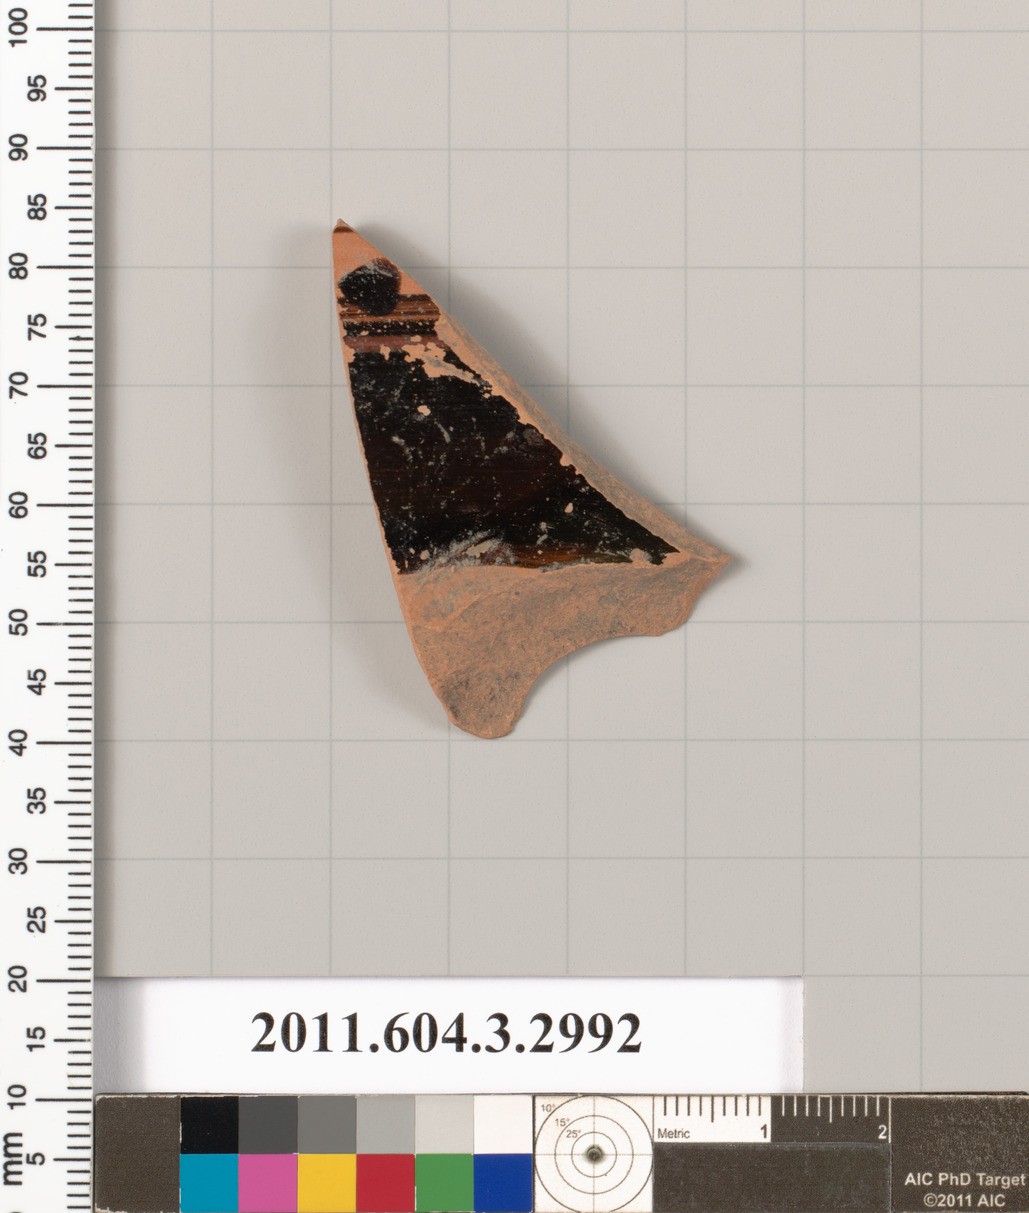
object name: undetermined shape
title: Terracotta fragment of an undetermined shape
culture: greek, attic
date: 534-468 BCE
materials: terracotta